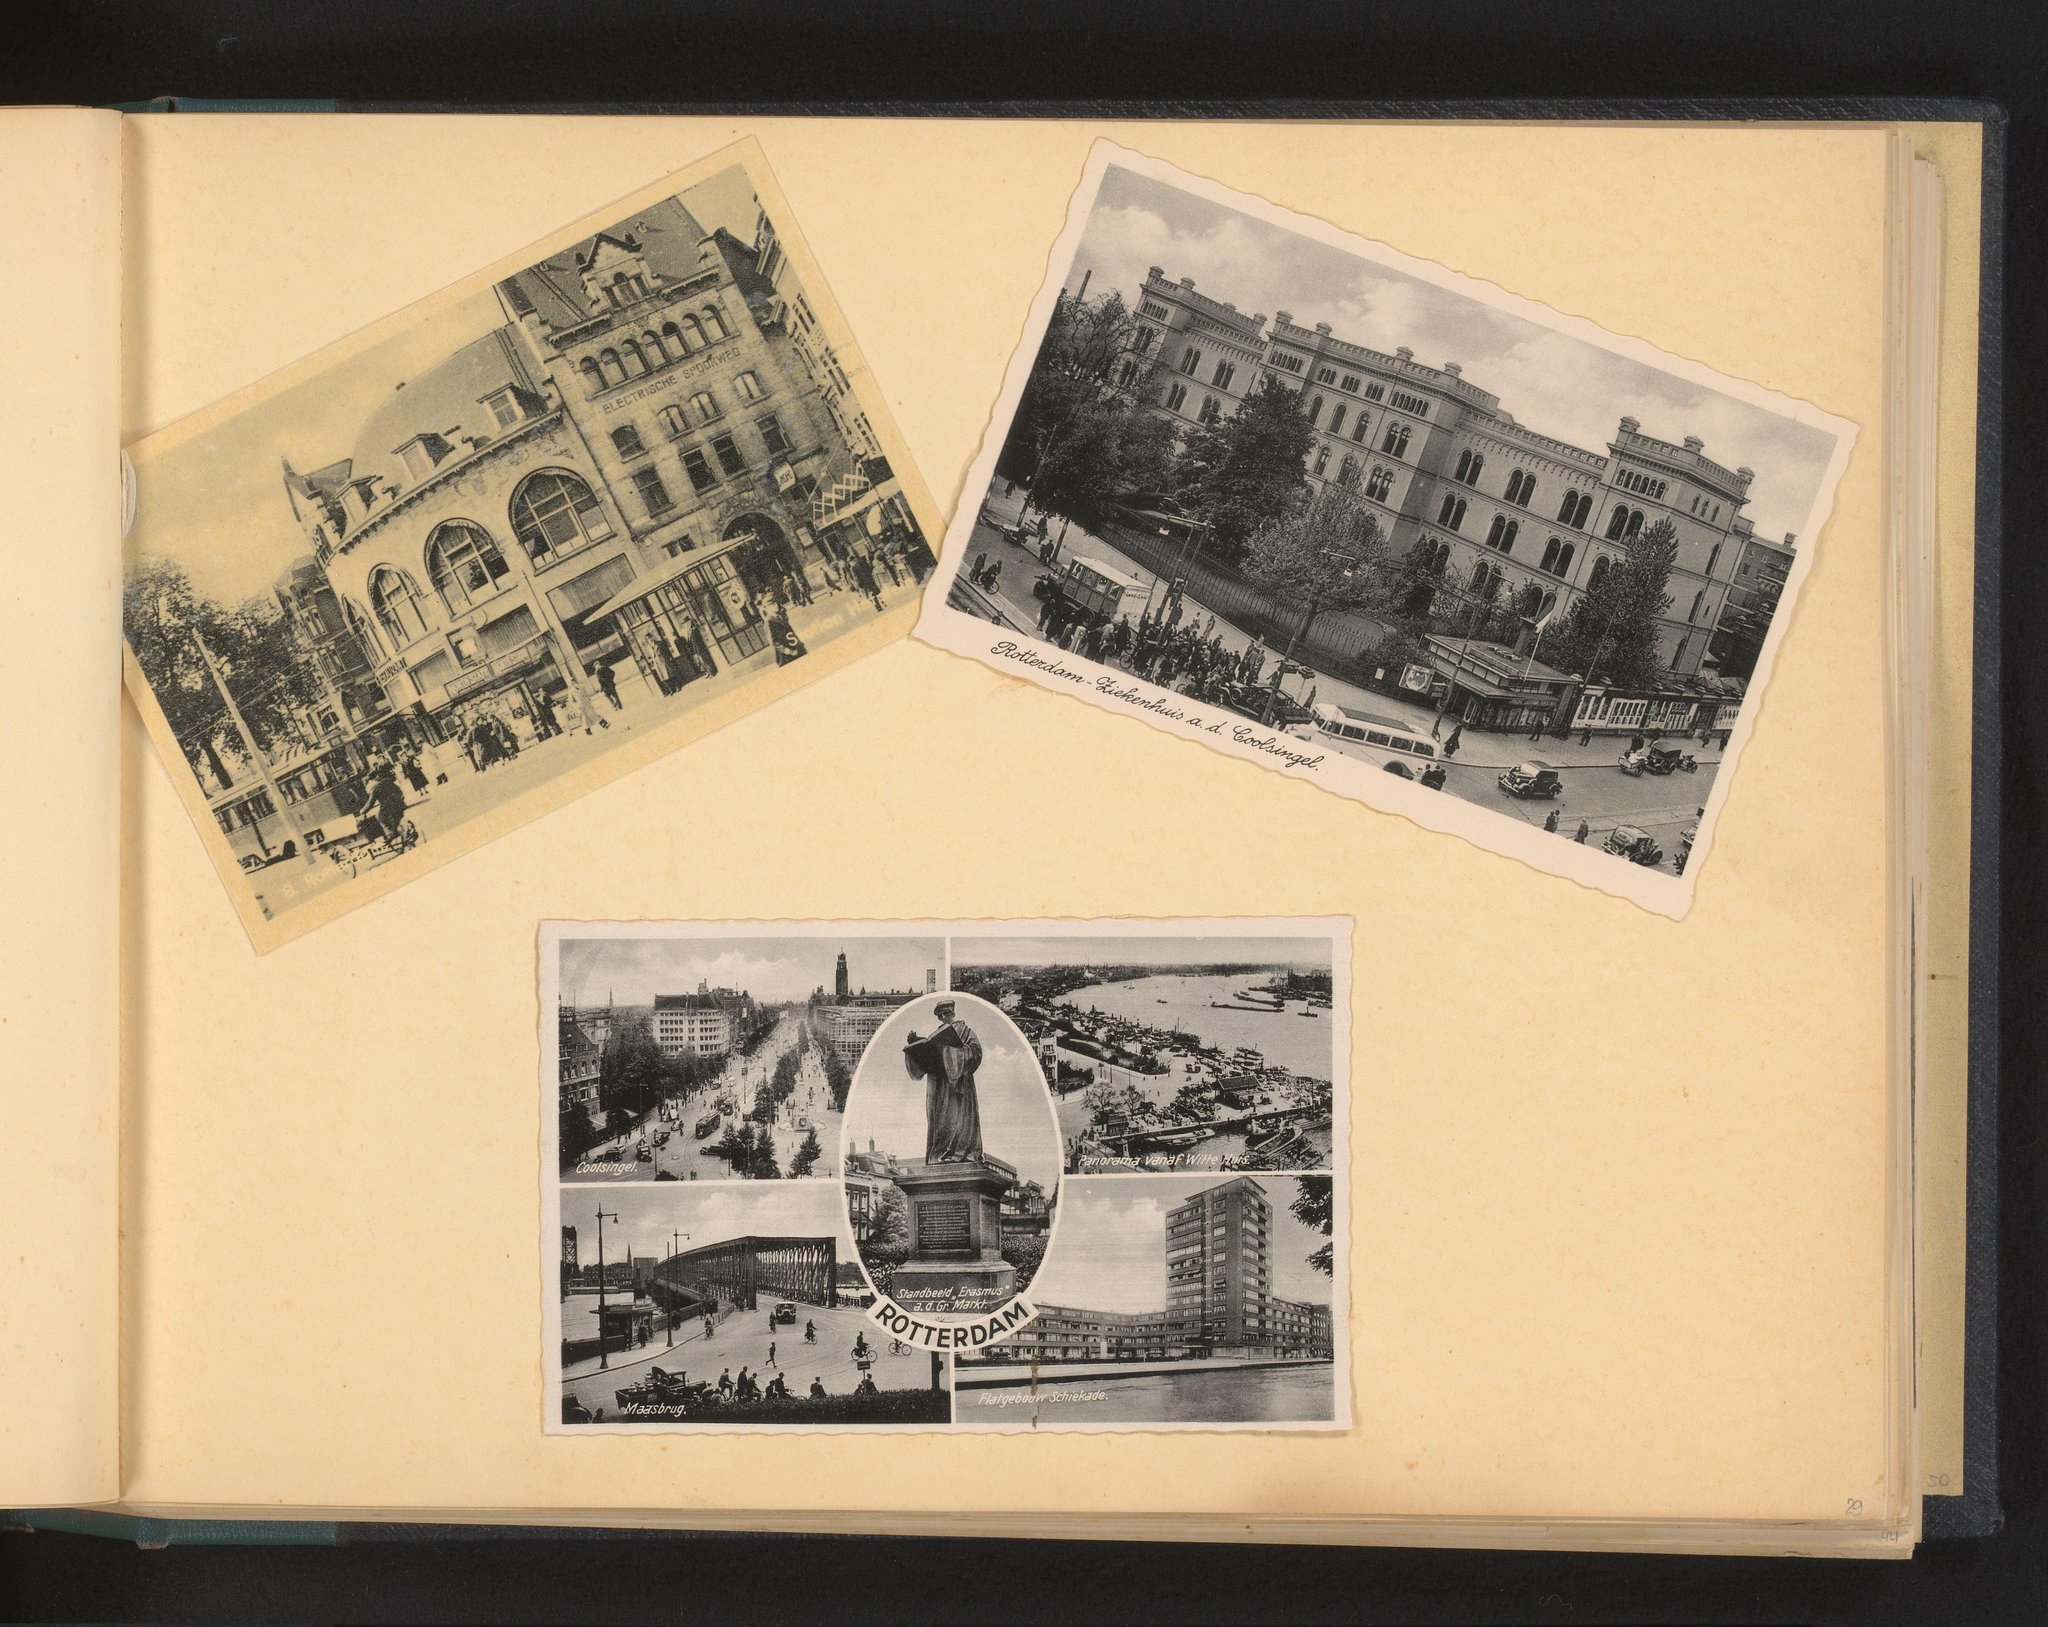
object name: album leaf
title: Gezichten te Rotterdam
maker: Anonymous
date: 1920-1940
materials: cardboard, photographic support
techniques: photograph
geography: rotterdam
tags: street (+ city(-scape) with figures, staffage), rotterdam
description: Albumblad met drie prentbriefkaarten van Station Hofplein, het ziekenhuis aan de Coolsingel en het standbeeld van Erasmus, te Rotterdam, voor het bombardement. Onderdeel van het fotoalbum over de verwoestingen van Nederlandse steden en infrastructuur in het begin van de Tweede Wereldoorlog.